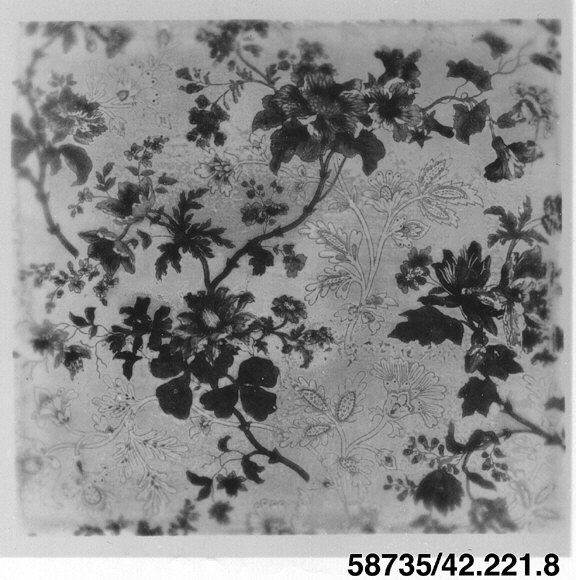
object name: piece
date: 1840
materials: linen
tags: flowers,leaves